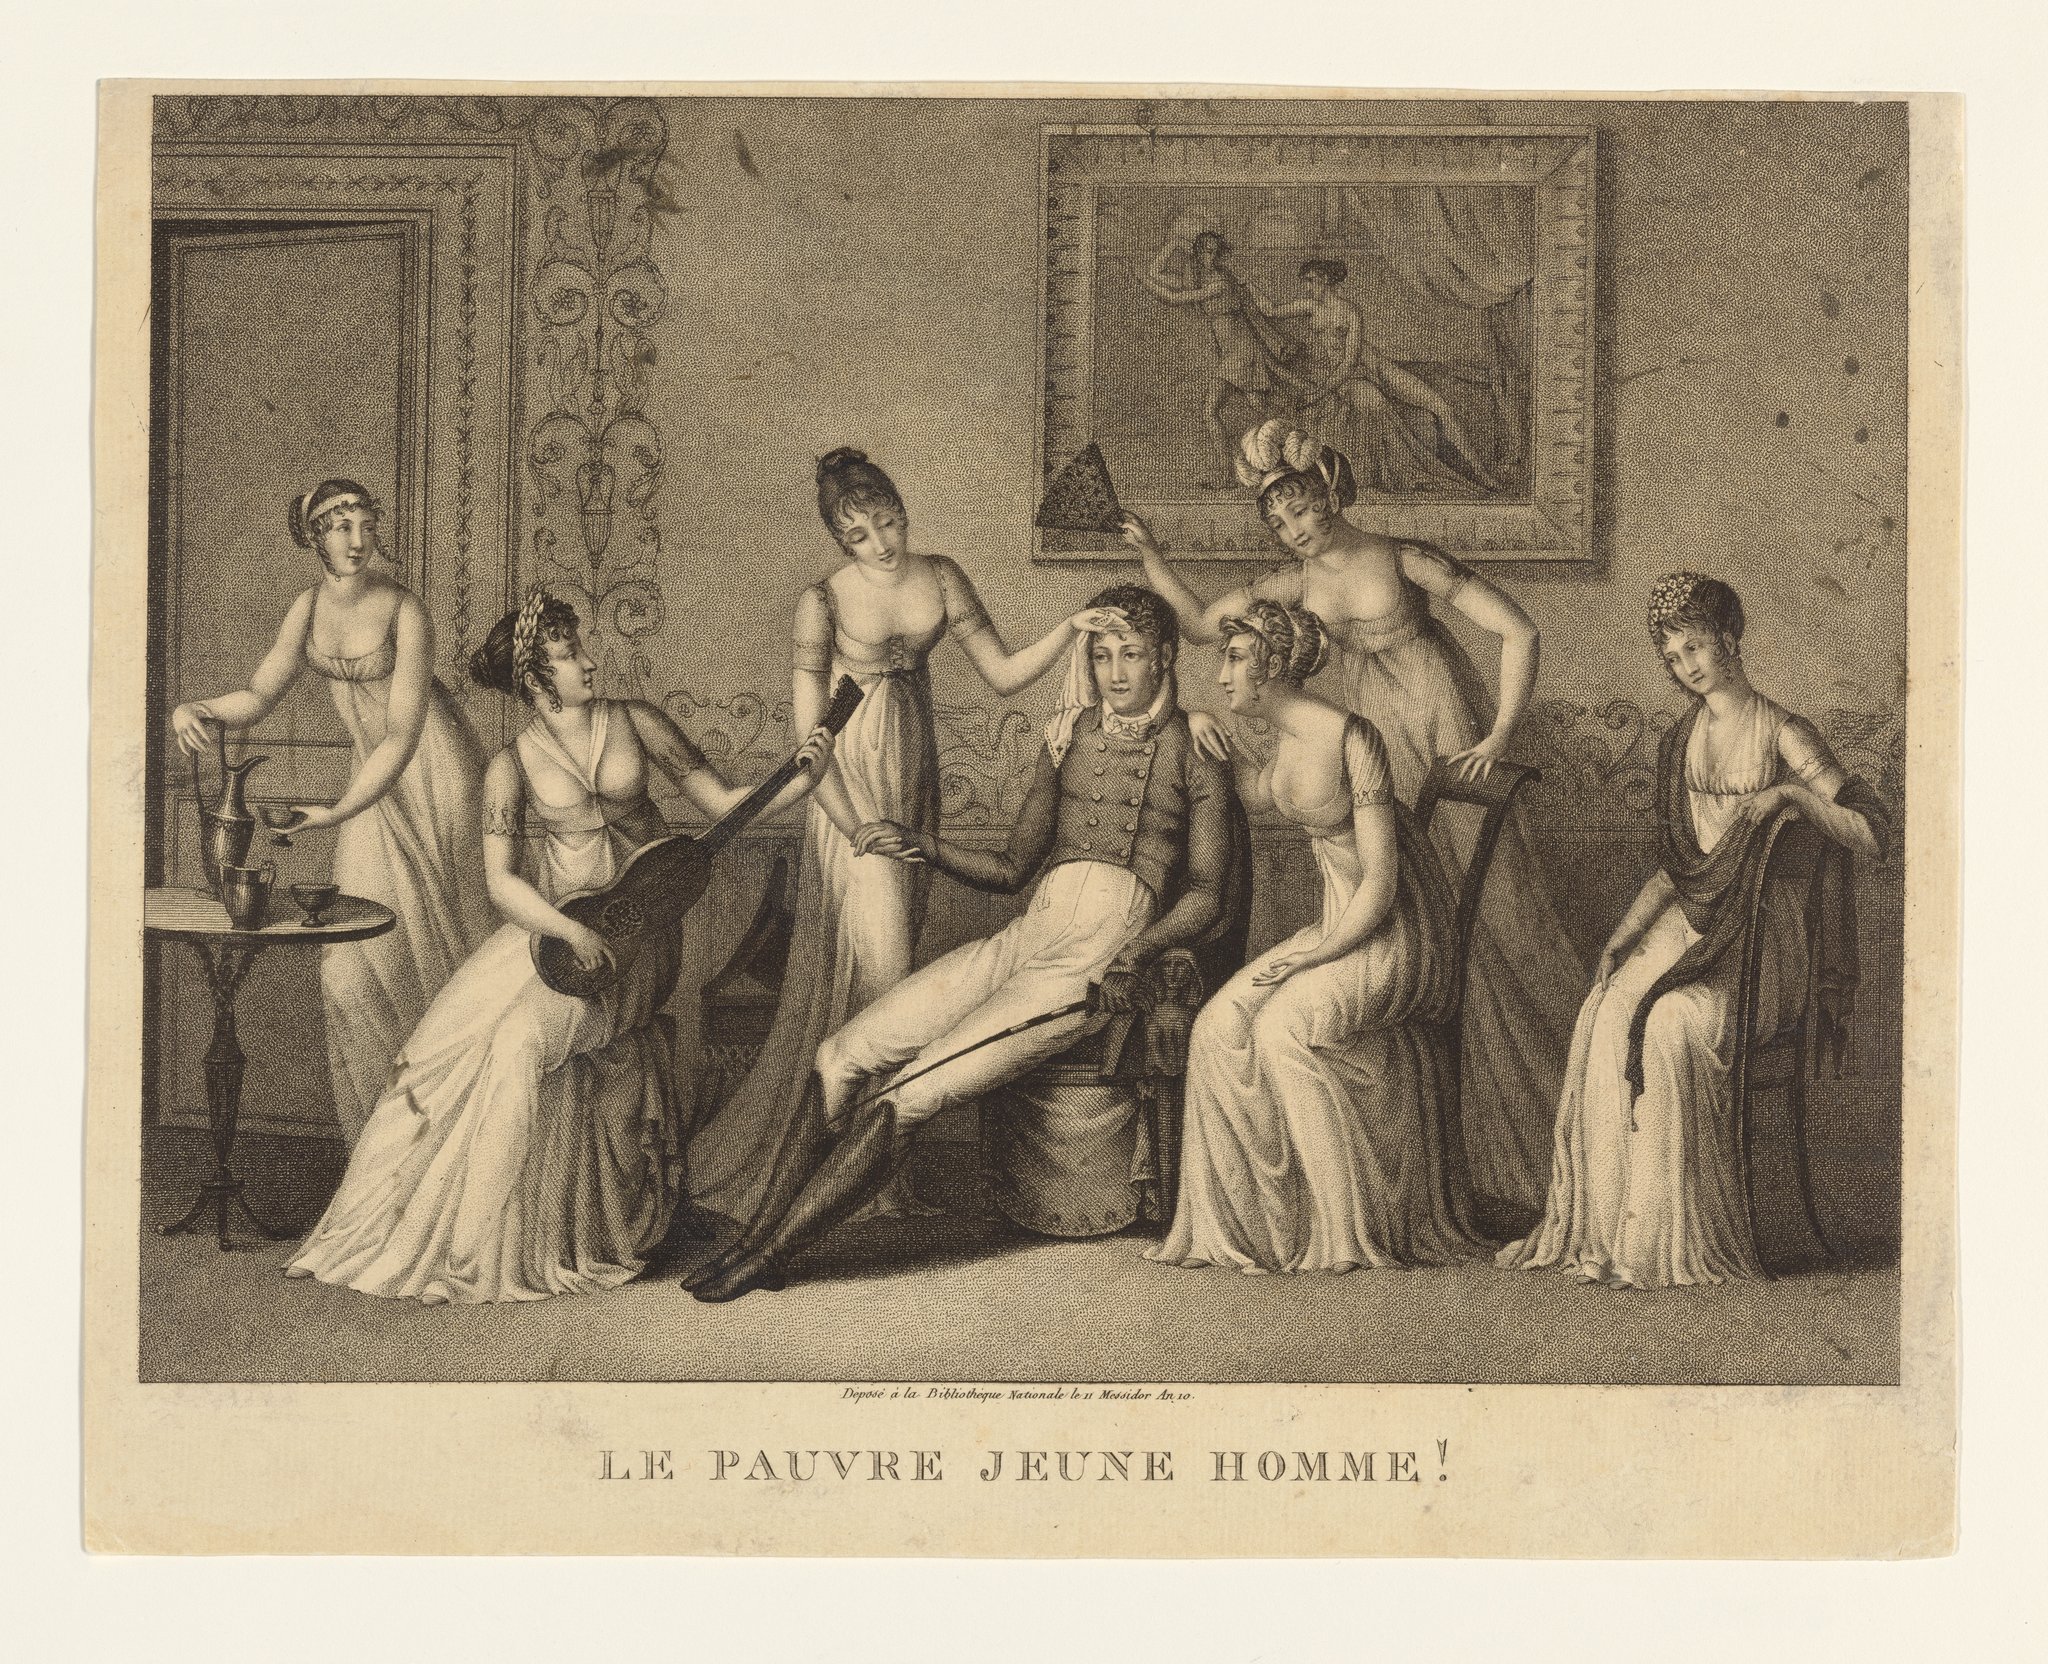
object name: print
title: Le pauvre jeune homme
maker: marguerite eléonore lingée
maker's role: artist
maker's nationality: french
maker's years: 1773-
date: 1802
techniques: engraving, etching